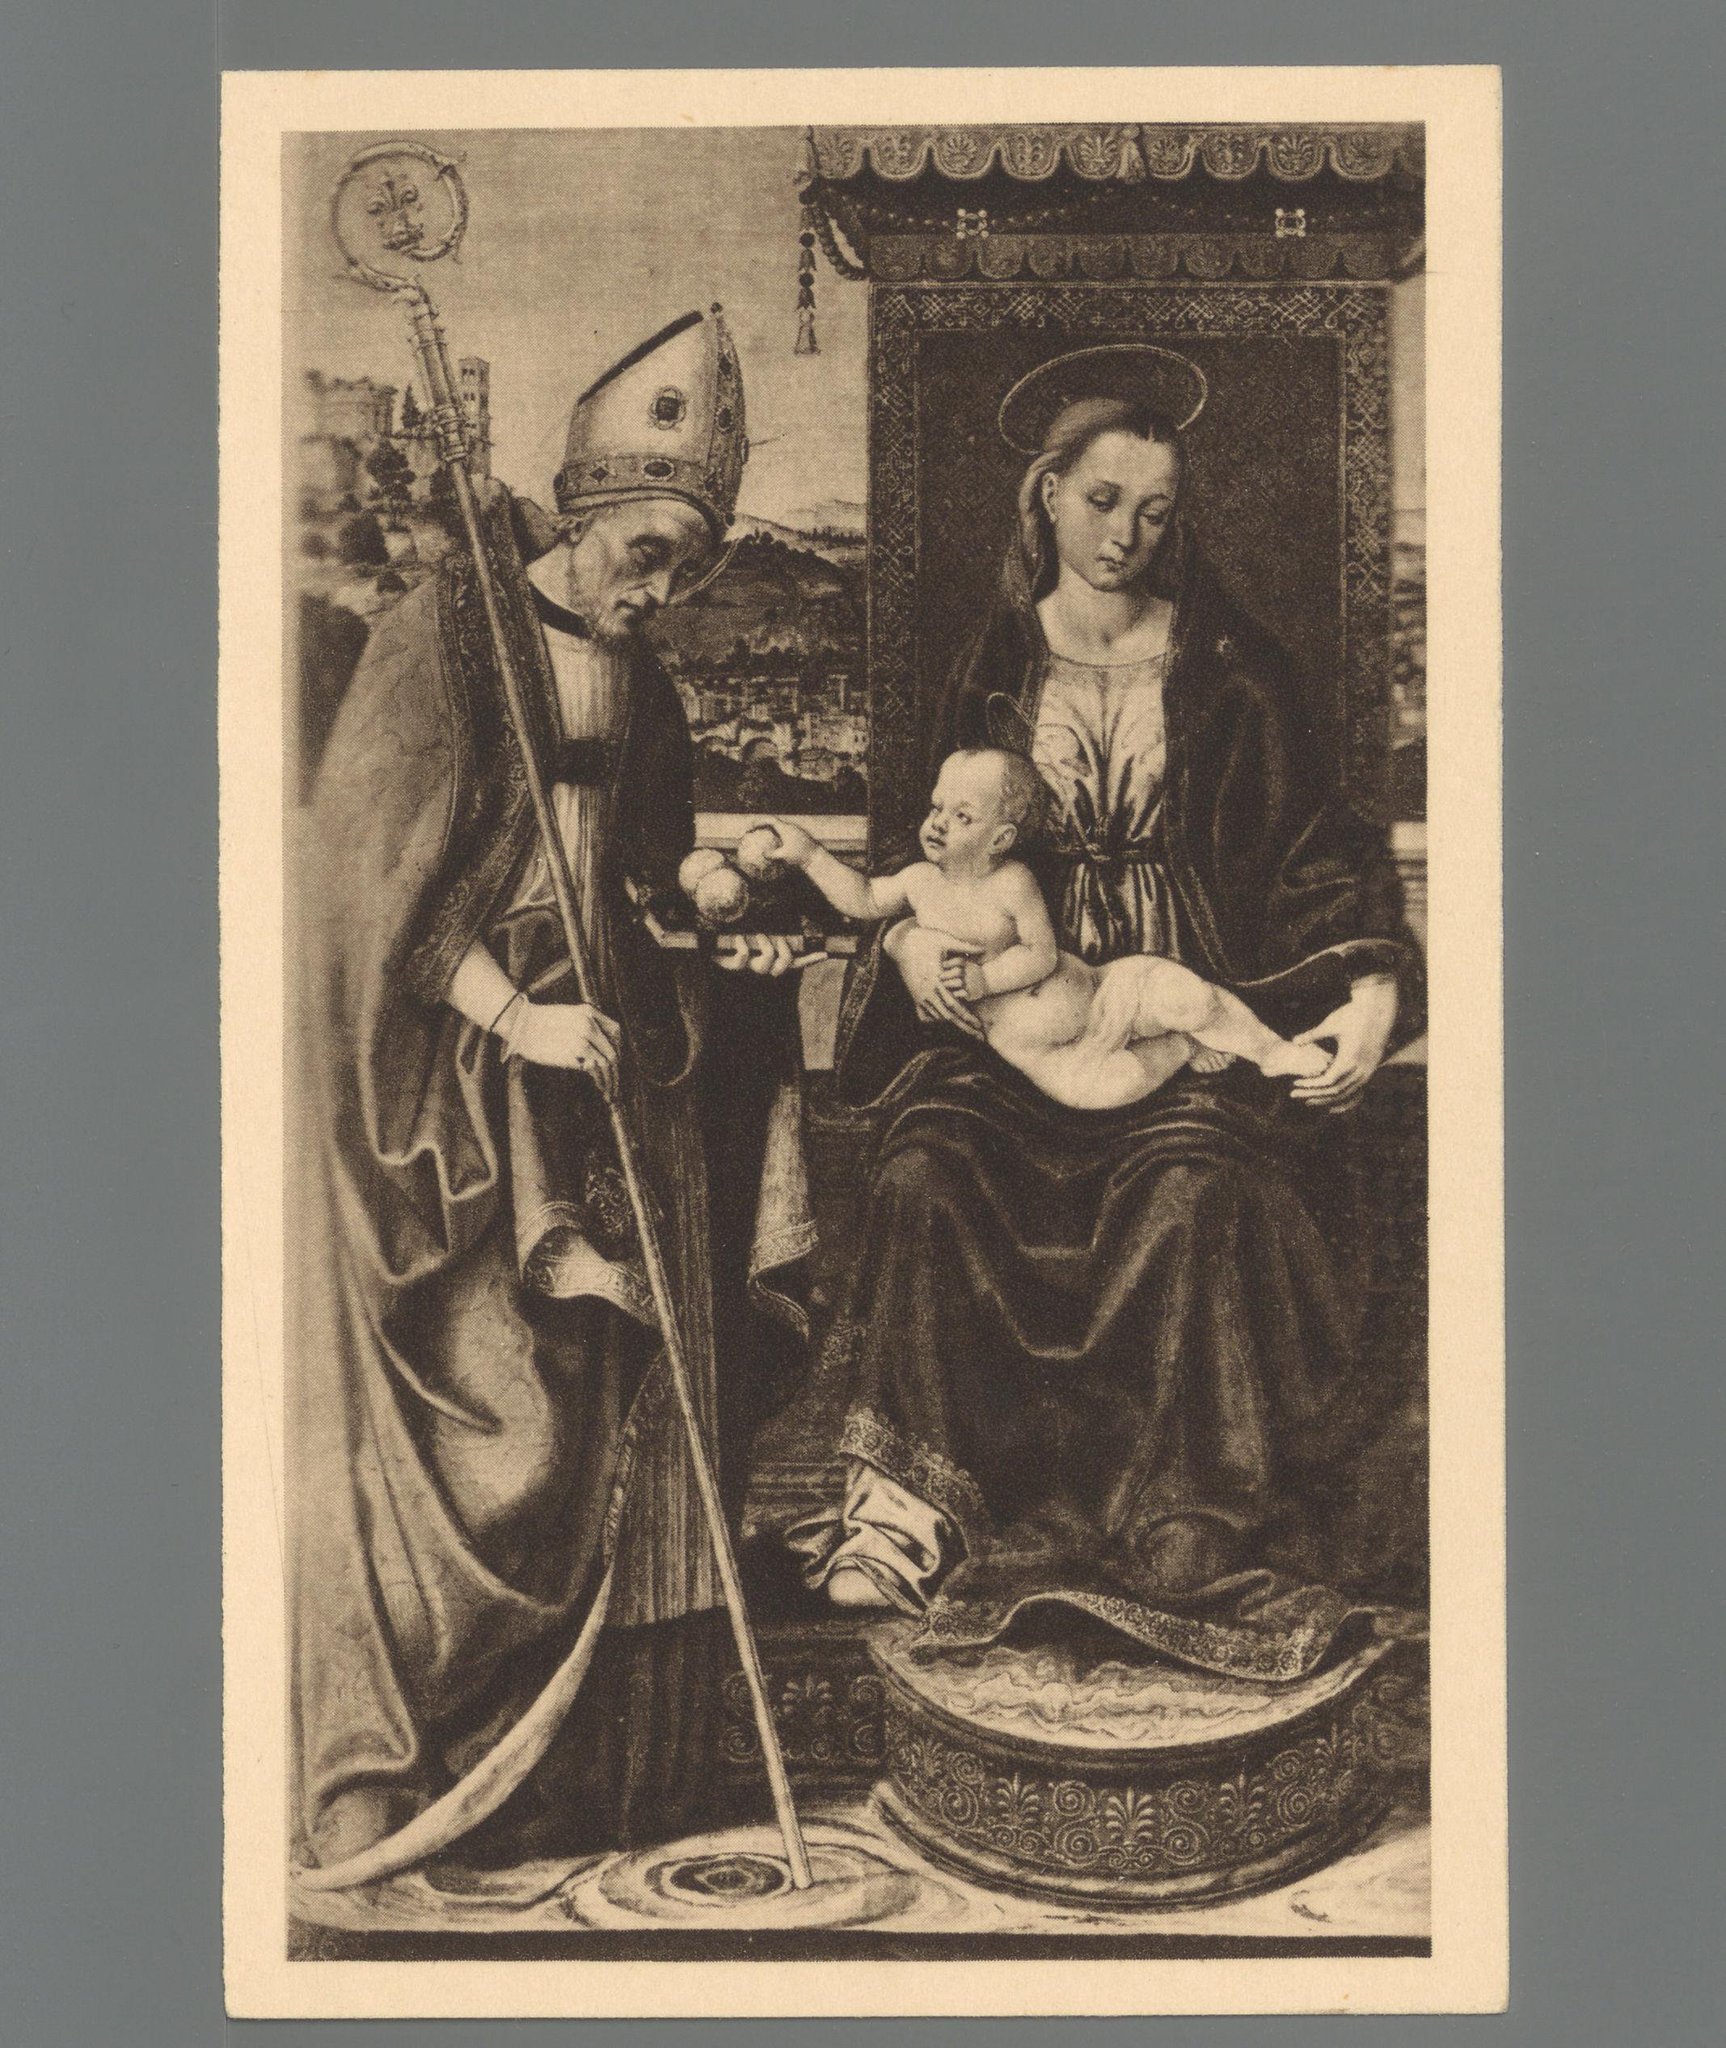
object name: photomechanical print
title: School van Ghirlandaio (omstreeks 1500). De HH. Nicolaas en Maria met Goddelijk Kind (gedeelte) - Rome, Galleria Capitolina.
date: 1928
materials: cardboard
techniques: rotogravure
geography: milan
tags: permanent exhibition, museum, picture, painting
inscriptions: collector's mark: ‘AFE v S’